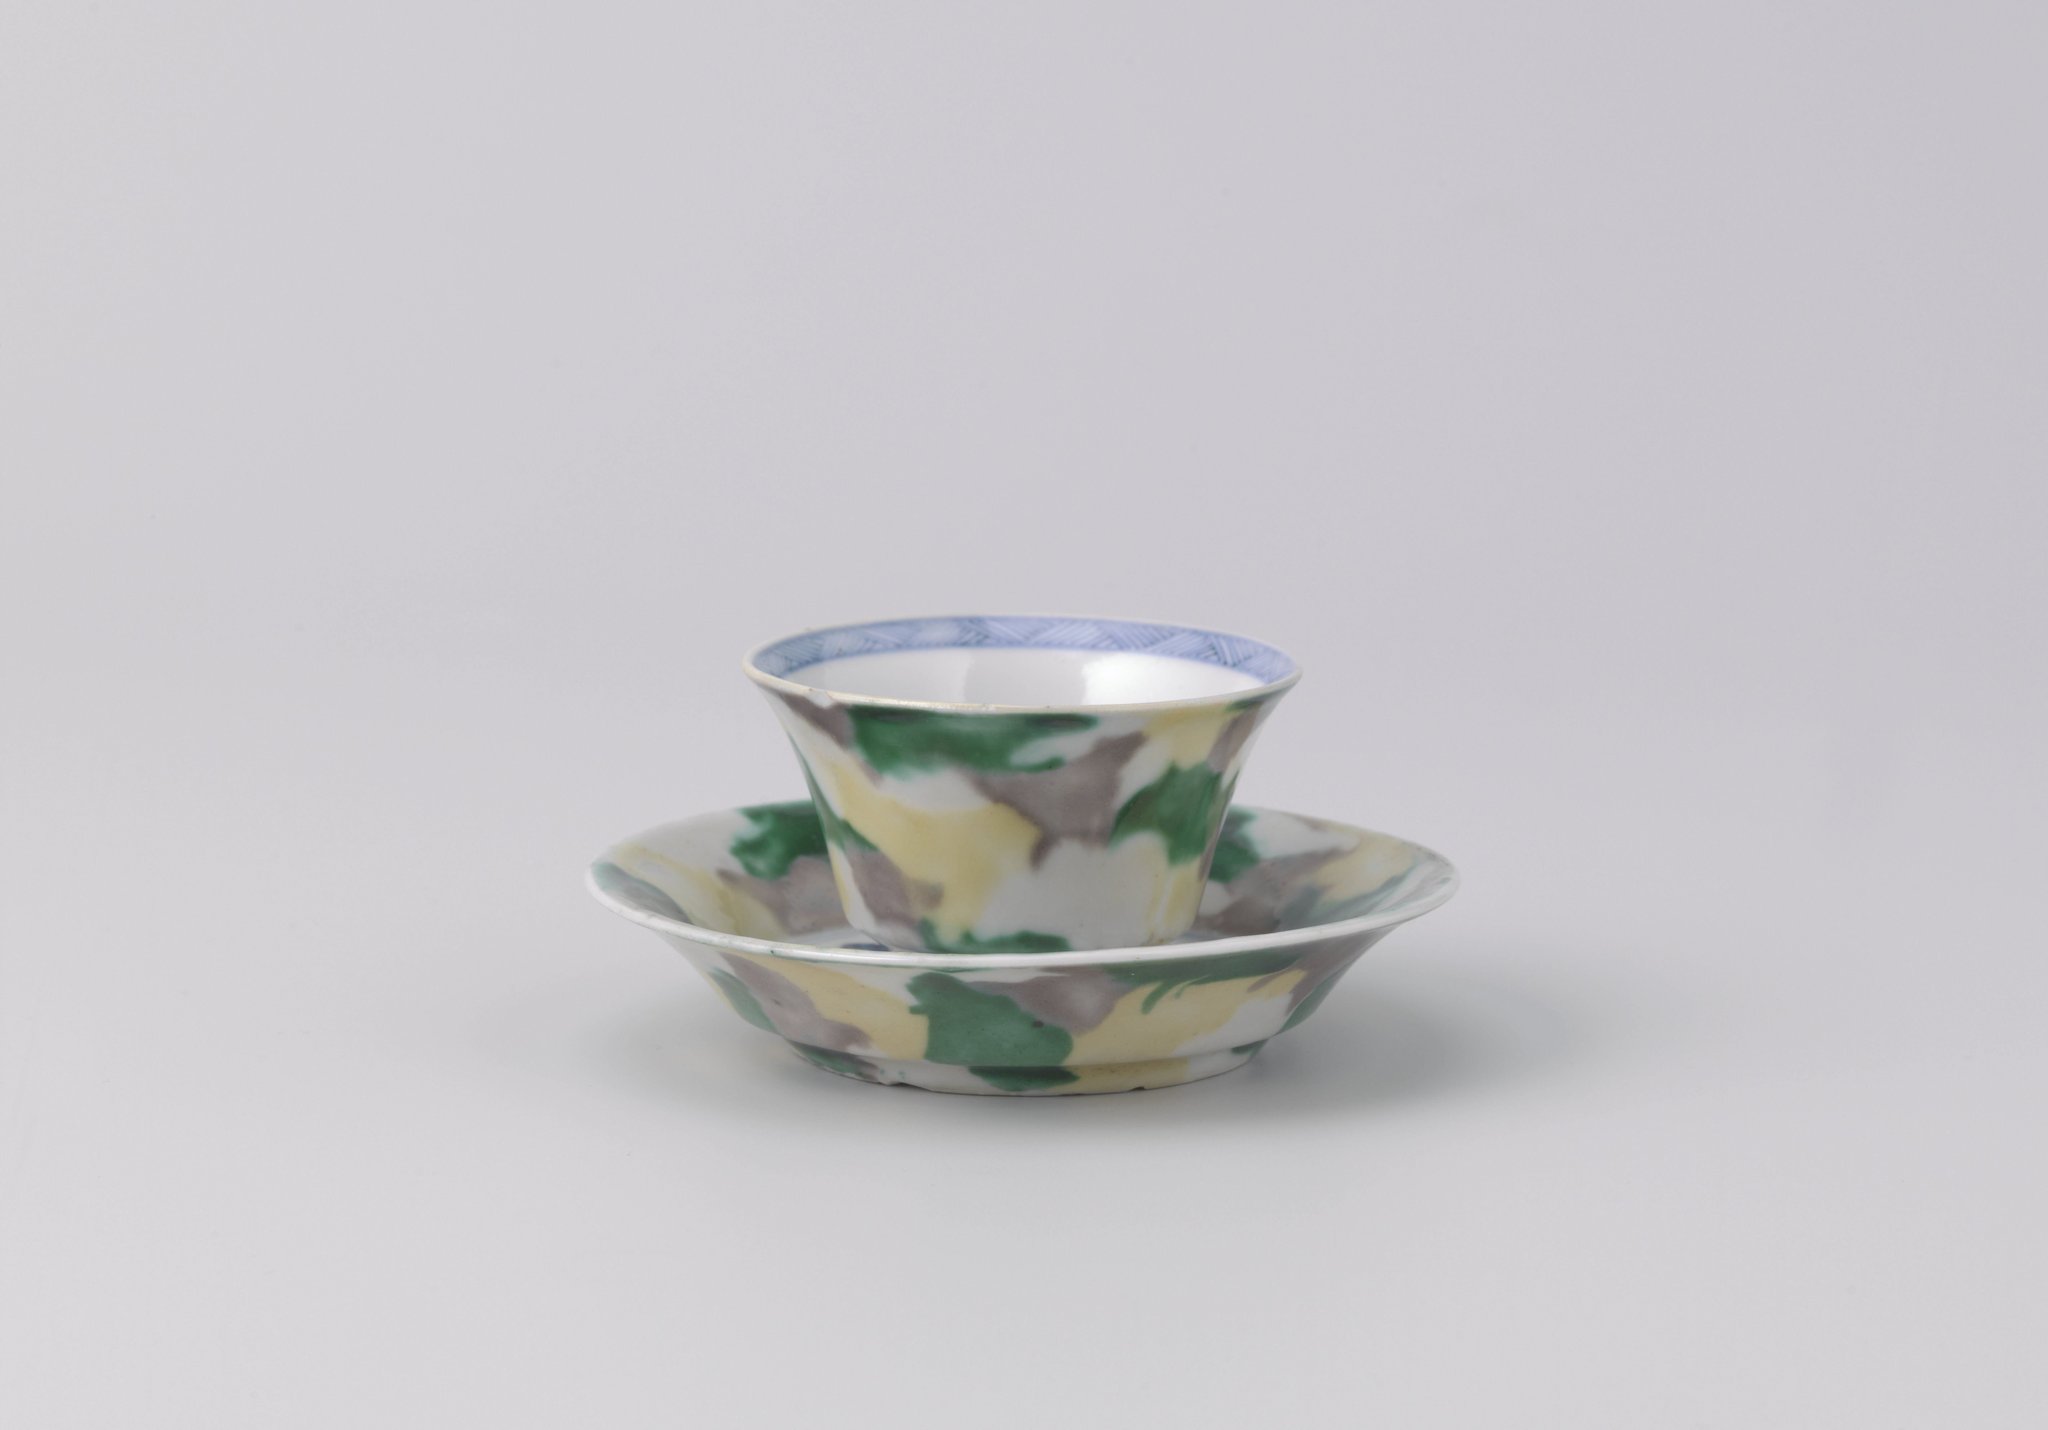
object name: kop en schotel, kop en schotel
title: Cup and saucer with 'egg and spinach' pattern and cock among plants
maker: Anonymous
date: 1680-1720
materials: cobalt, glaze, paint, porcelain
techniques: firing, turning, vitrification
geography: china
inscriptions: mark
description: Kop en (diepe) schotel van porselein, beschilderd in onderglazuur blauw en op het glazuur groen, geel en aubergine. Op het plat van de schotel een haan naast bamboe en een bloeiende plant; de wand aan binnen- en buitenzijde bedekt met een 'egg and spinach' patroon. De kop heeft het 'egg and spinach' patroon aan de buitenzijde en een haan aan de binnenzijde. Beide gemerkt op de onderzijde met een paddenstoel (lingzhi). Famille verte.